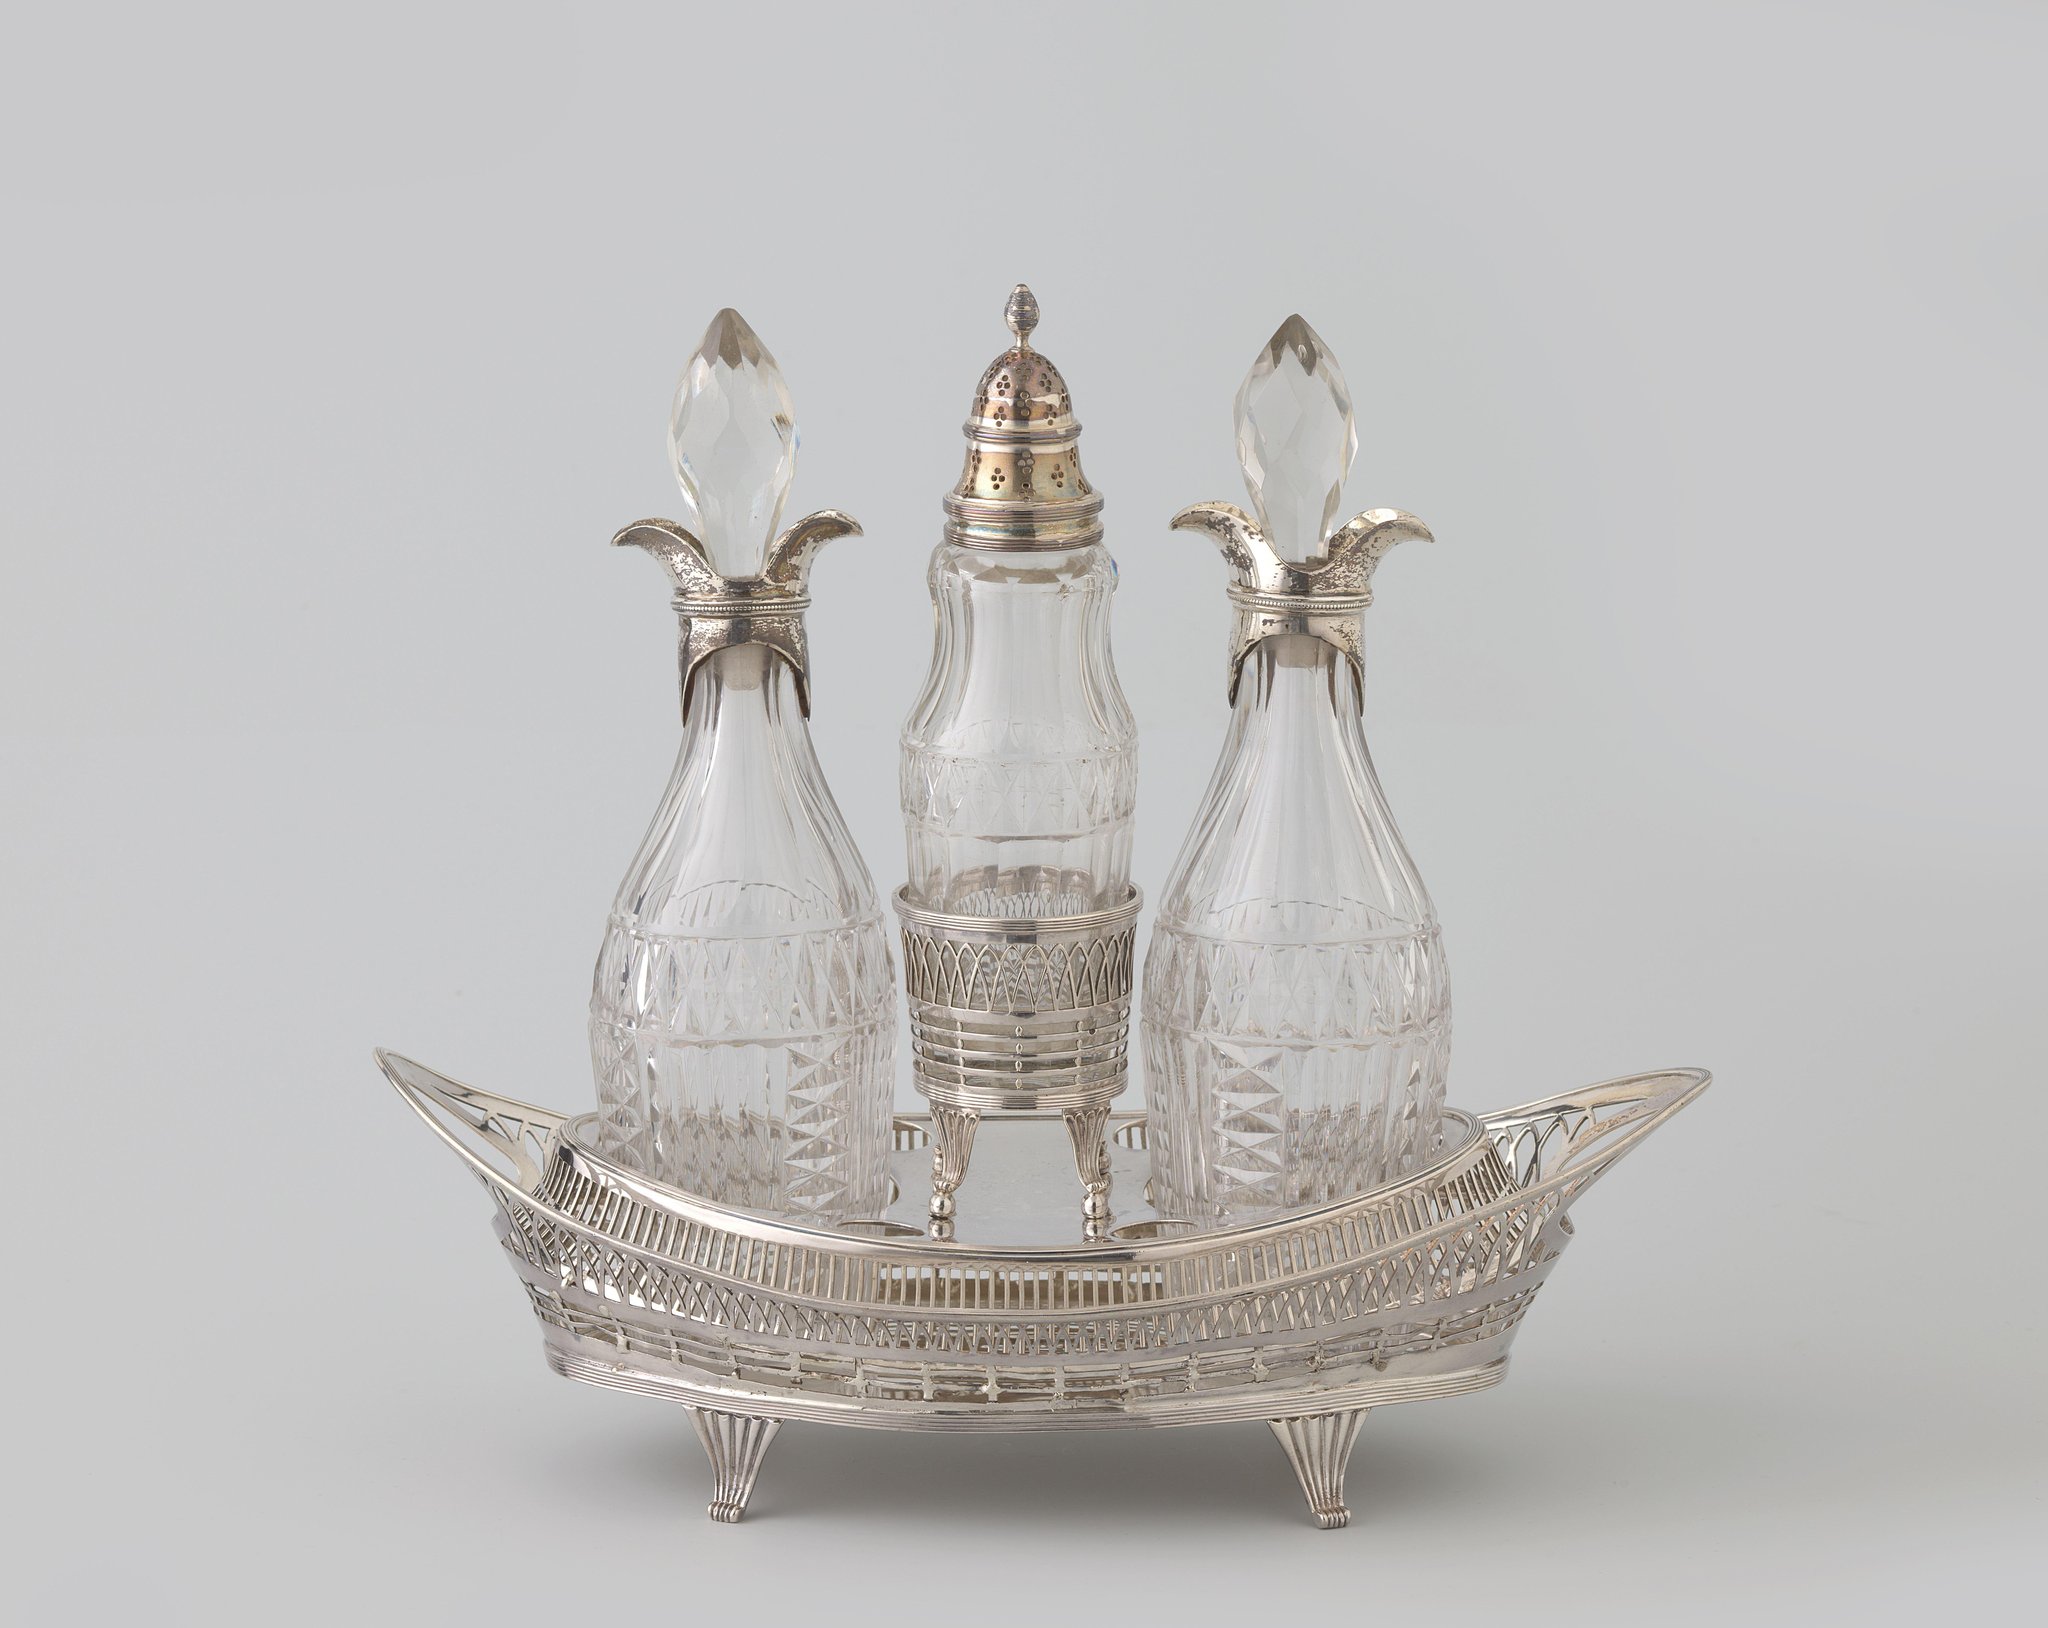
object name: bung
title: Fles met stop behorende bij olie- en azijnstel bestaande uit twee flessen en een strooibus in spitsovale houder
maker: hendrik smits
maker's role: silversmith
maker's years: 1772-1841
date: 1803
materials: glass, silver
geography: amsterdam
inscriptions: mark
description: Fles van kleurloos glas, versierd in divers slijpwerk, bestemd voor olie of azijn. Het bovenste gedeelte van de fles is gevat in een zilveren montuur die versierd is met een parelrand tussen profielranden. Aan de onderzijde eindigt de montuur voor en achter in een punt, aan de bovenzijde voor en achter in een snebvormige tuit. De fles heeft een druppelvormige, in facetpatroon geslepen stop.